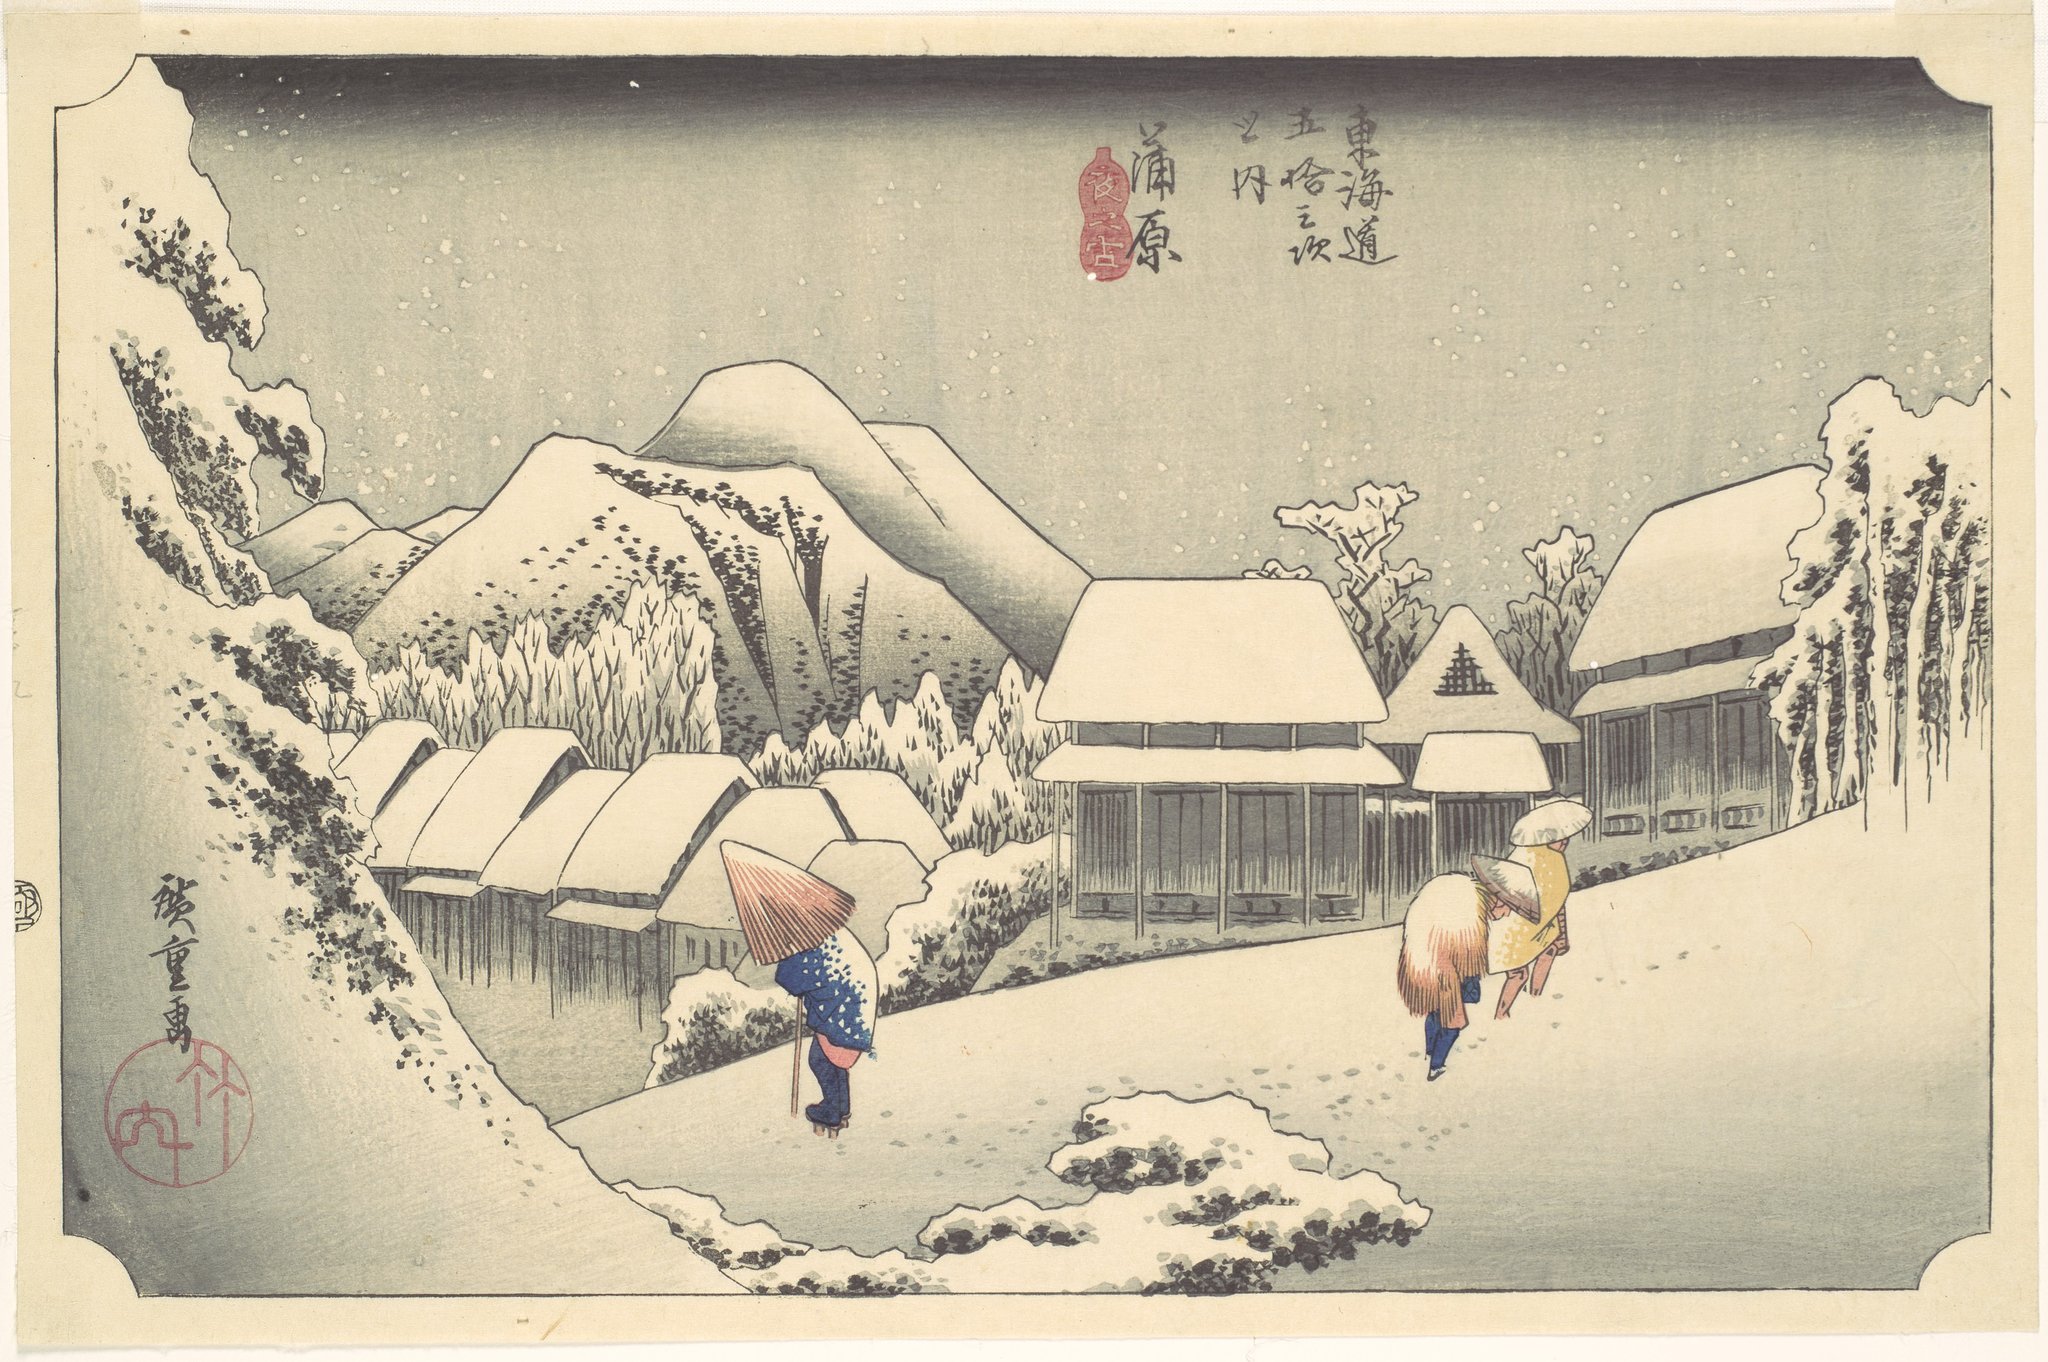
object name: woodblock print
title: Evening Snow at Kanbara, from the series "Fifty-three Stations of the Tōkaidō"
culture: japanese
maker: utagawa hiroshige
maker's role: artist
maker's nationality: japanese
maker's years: 1797-1858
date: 1833-1834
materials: ink, paper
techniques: woodblock print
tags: houses,mountains,snow